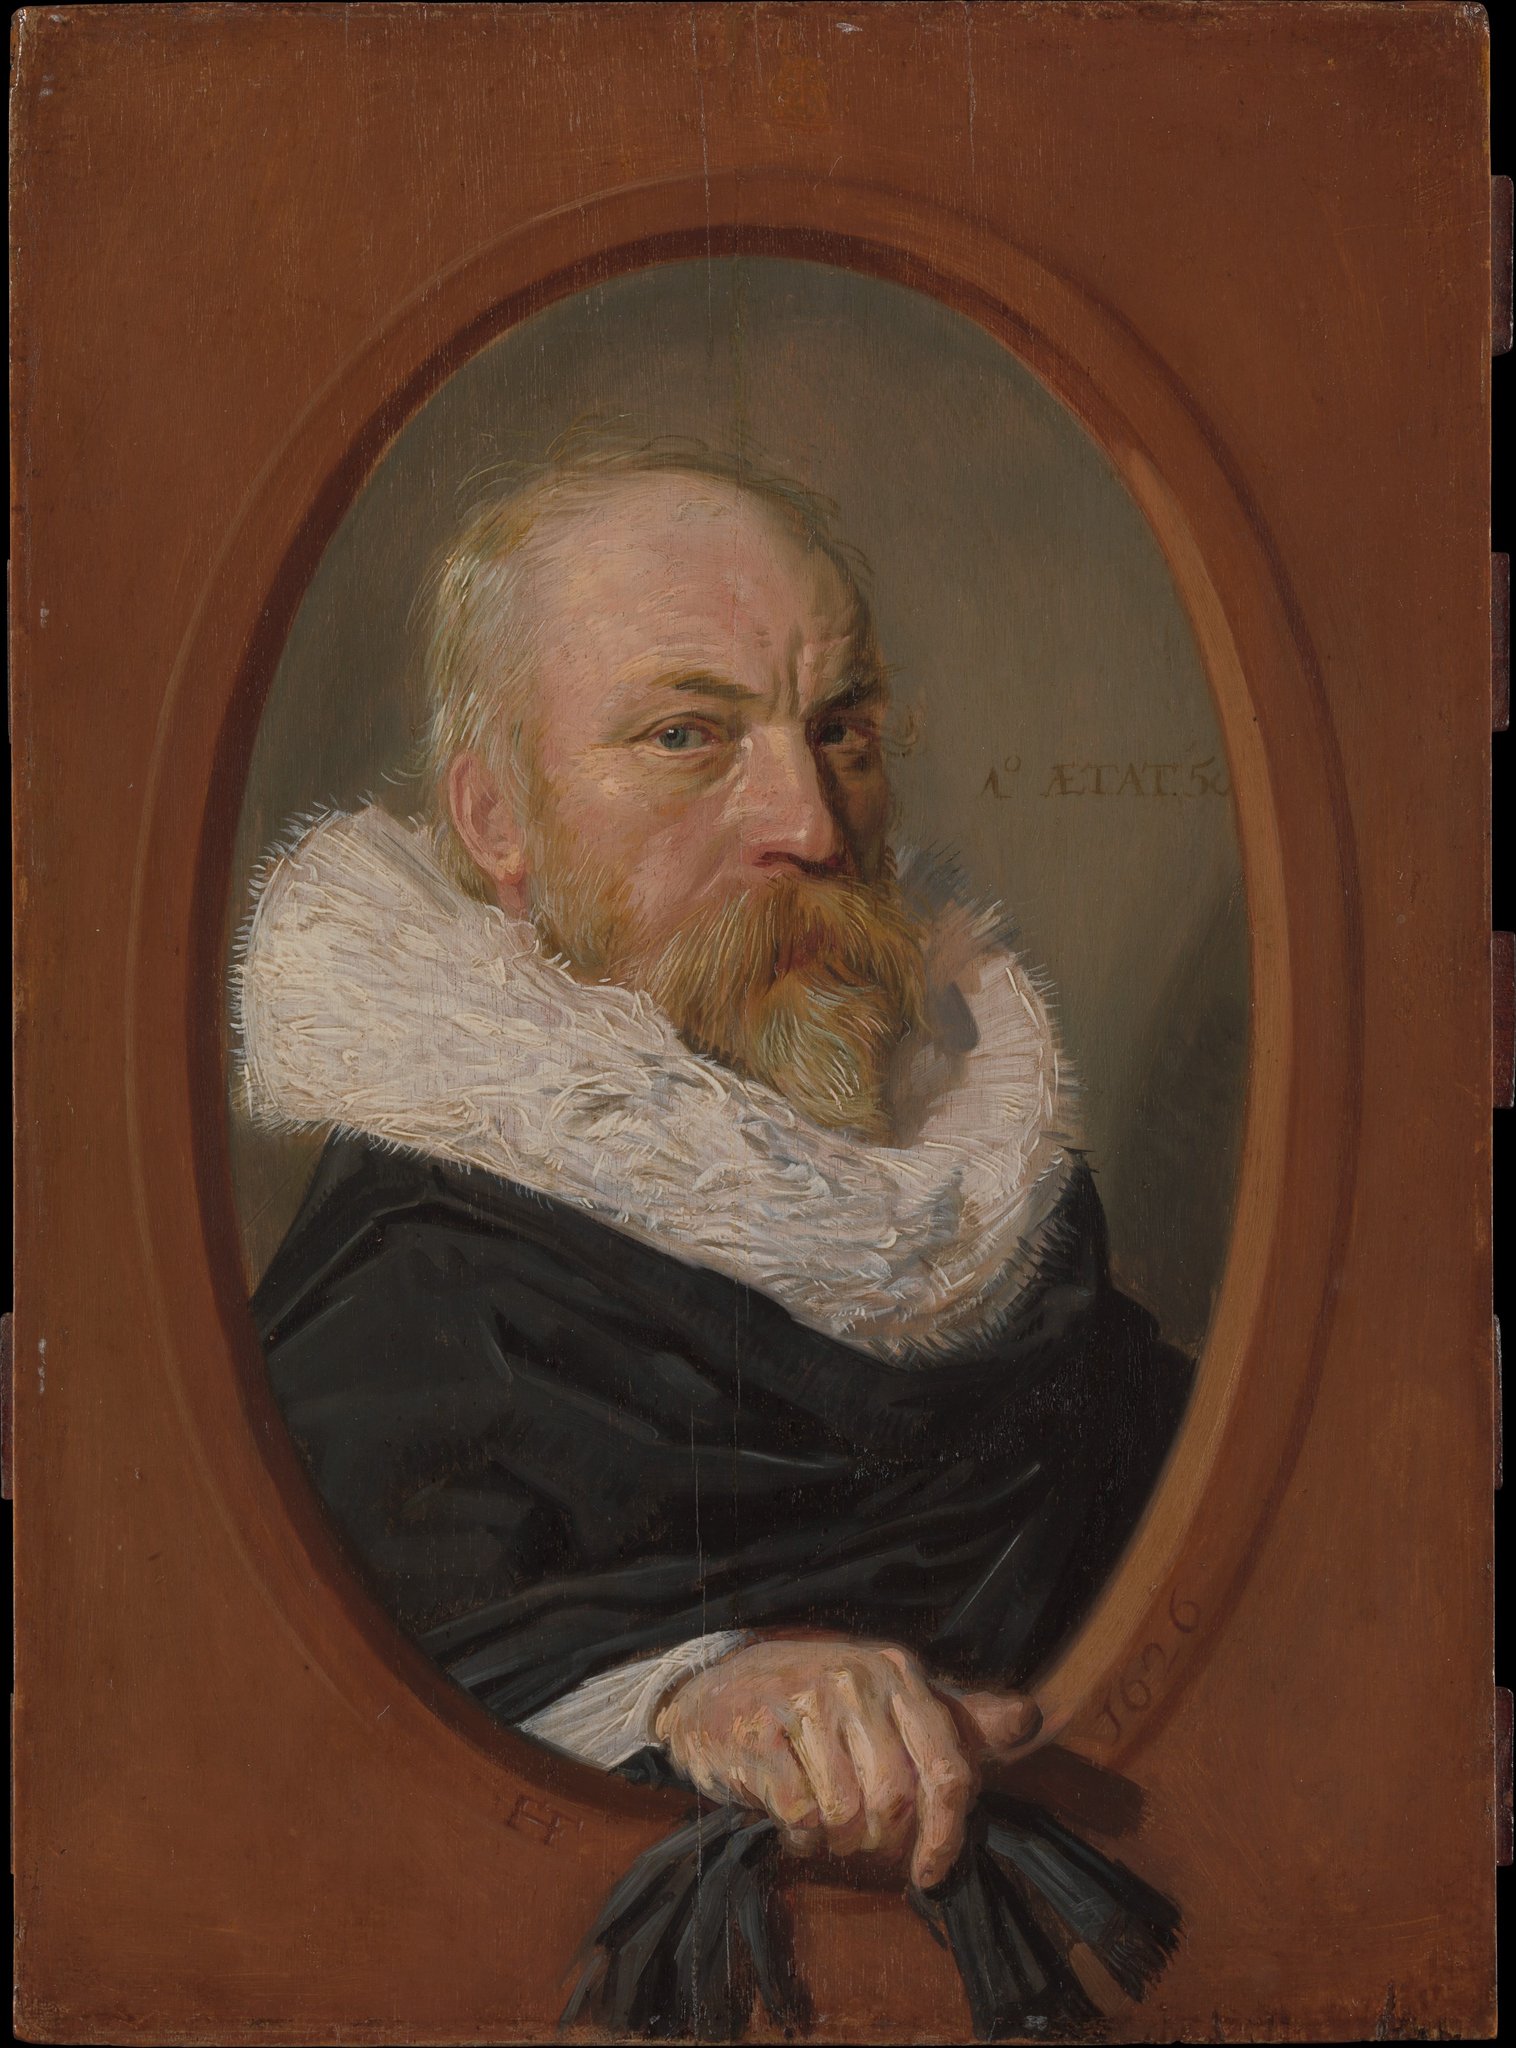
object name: painting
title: Petrus Scriverius (1576–1660)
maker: frans hals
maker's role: artist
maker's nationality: dutch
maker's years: 1582-1666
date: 1626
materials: oil, wood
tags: men,portraits